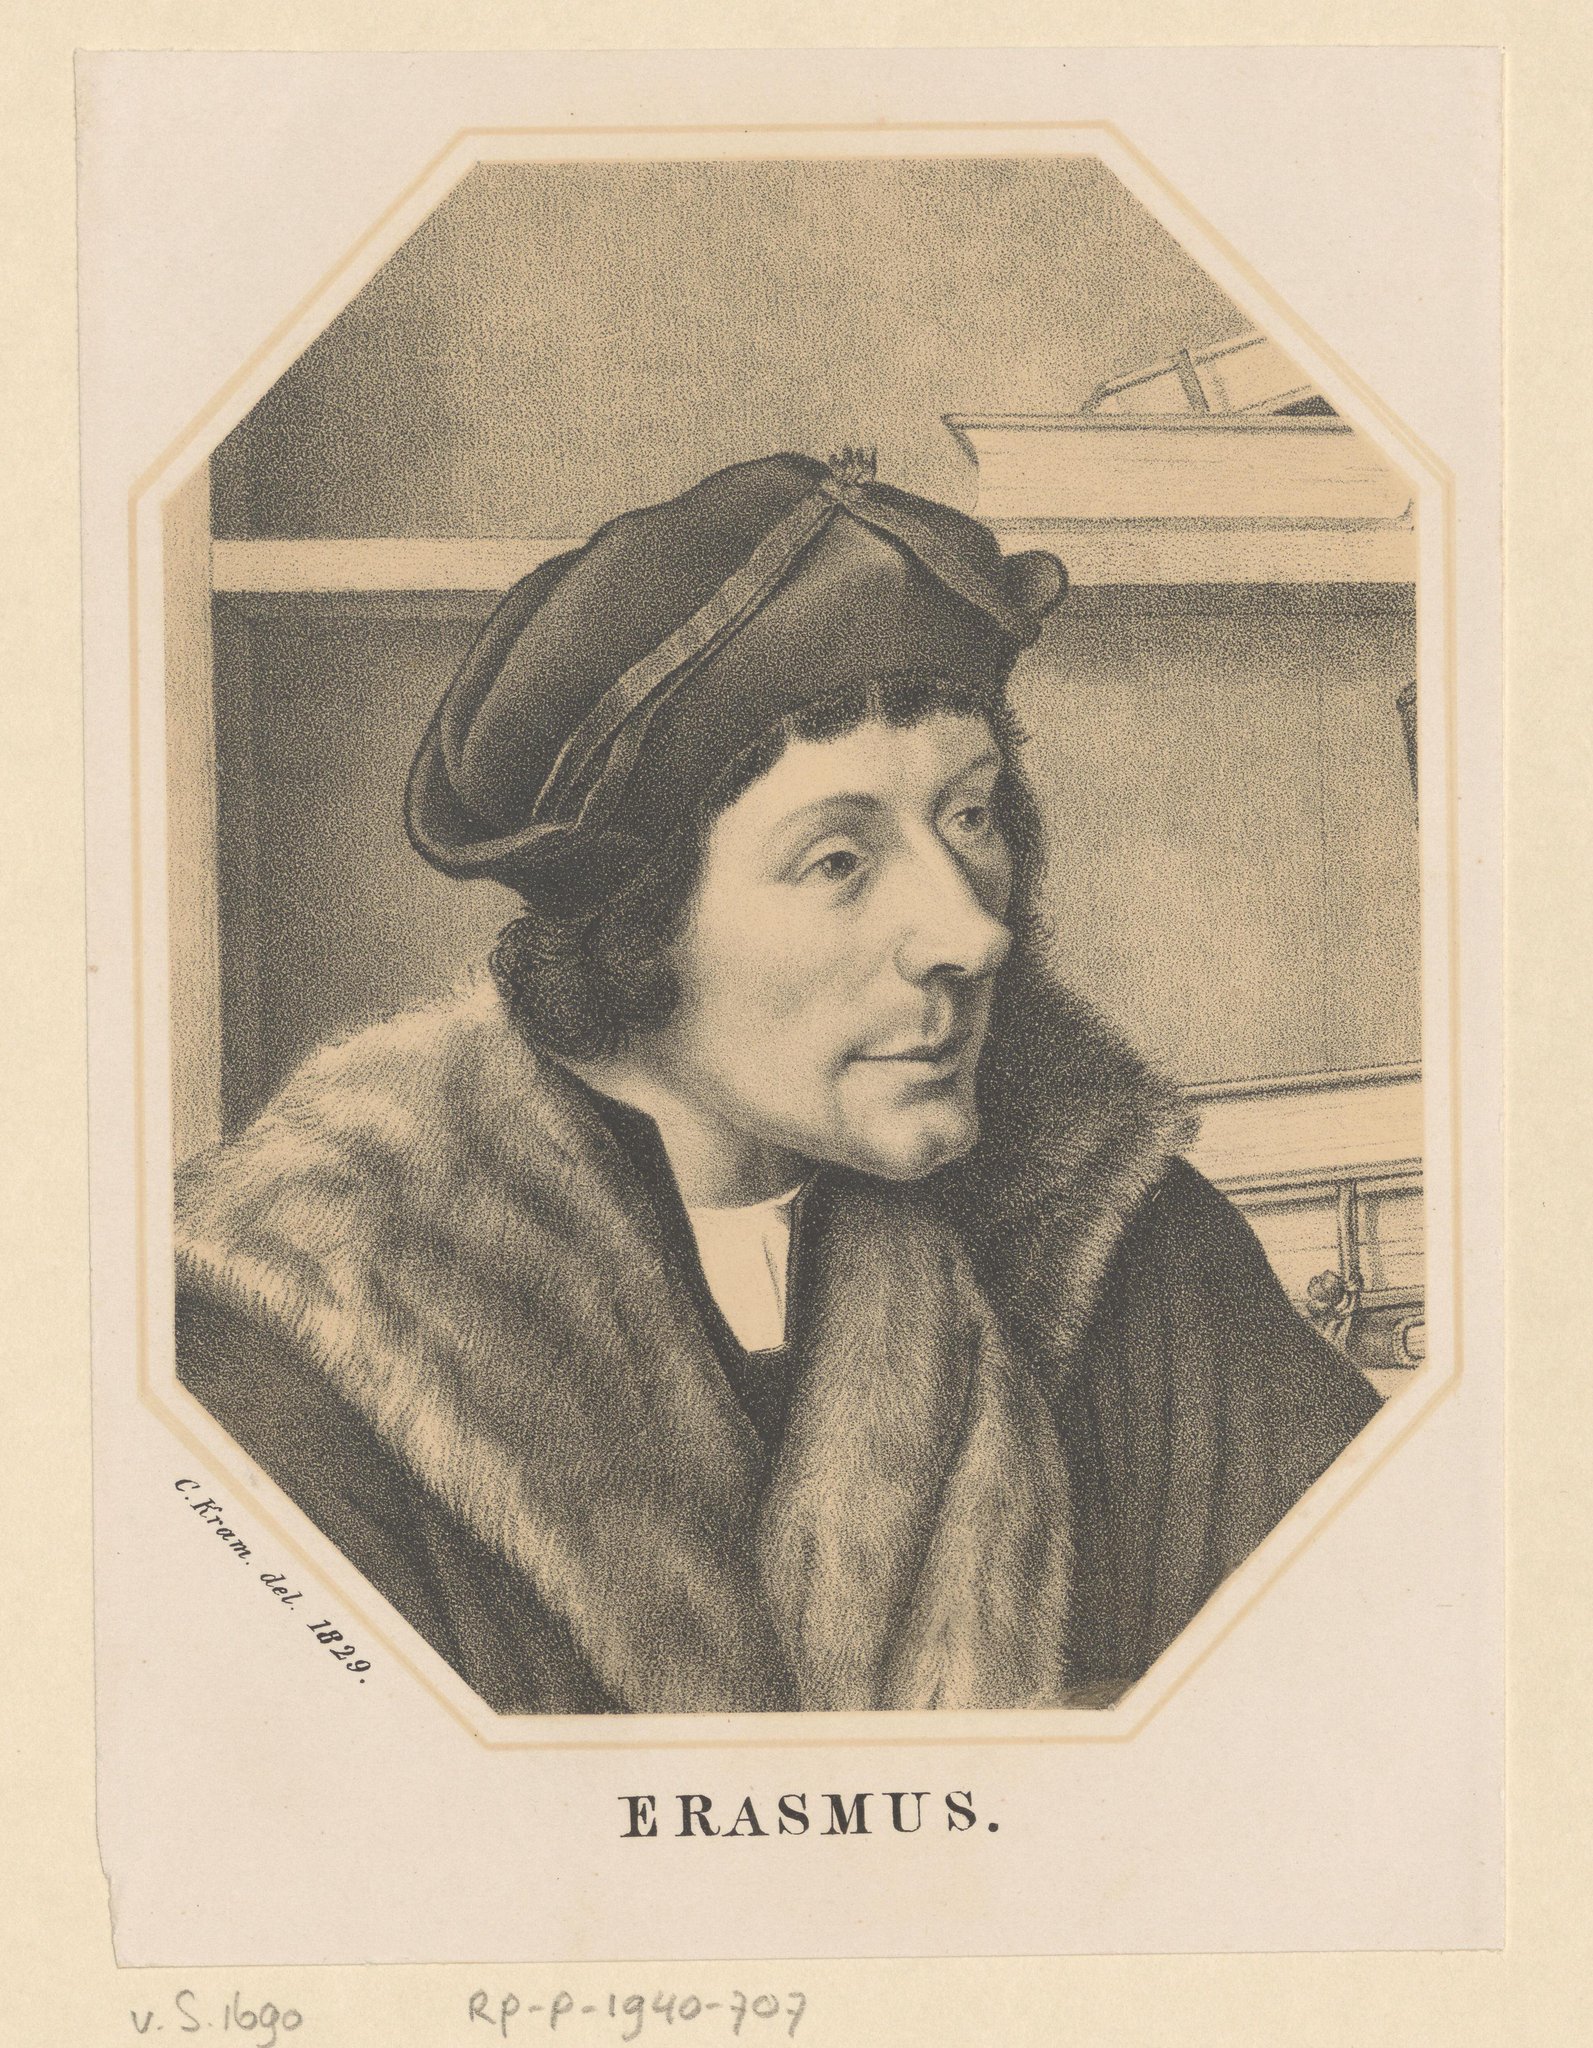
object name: print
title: Portret van Desiderius Erasmus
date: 1829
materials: paper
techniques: tone lithography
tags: rotterdam, desiderius erasmus, bookshelves, historical persons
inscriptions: collector's mark: Lugt 2228, collector's mark: Lugt 2760